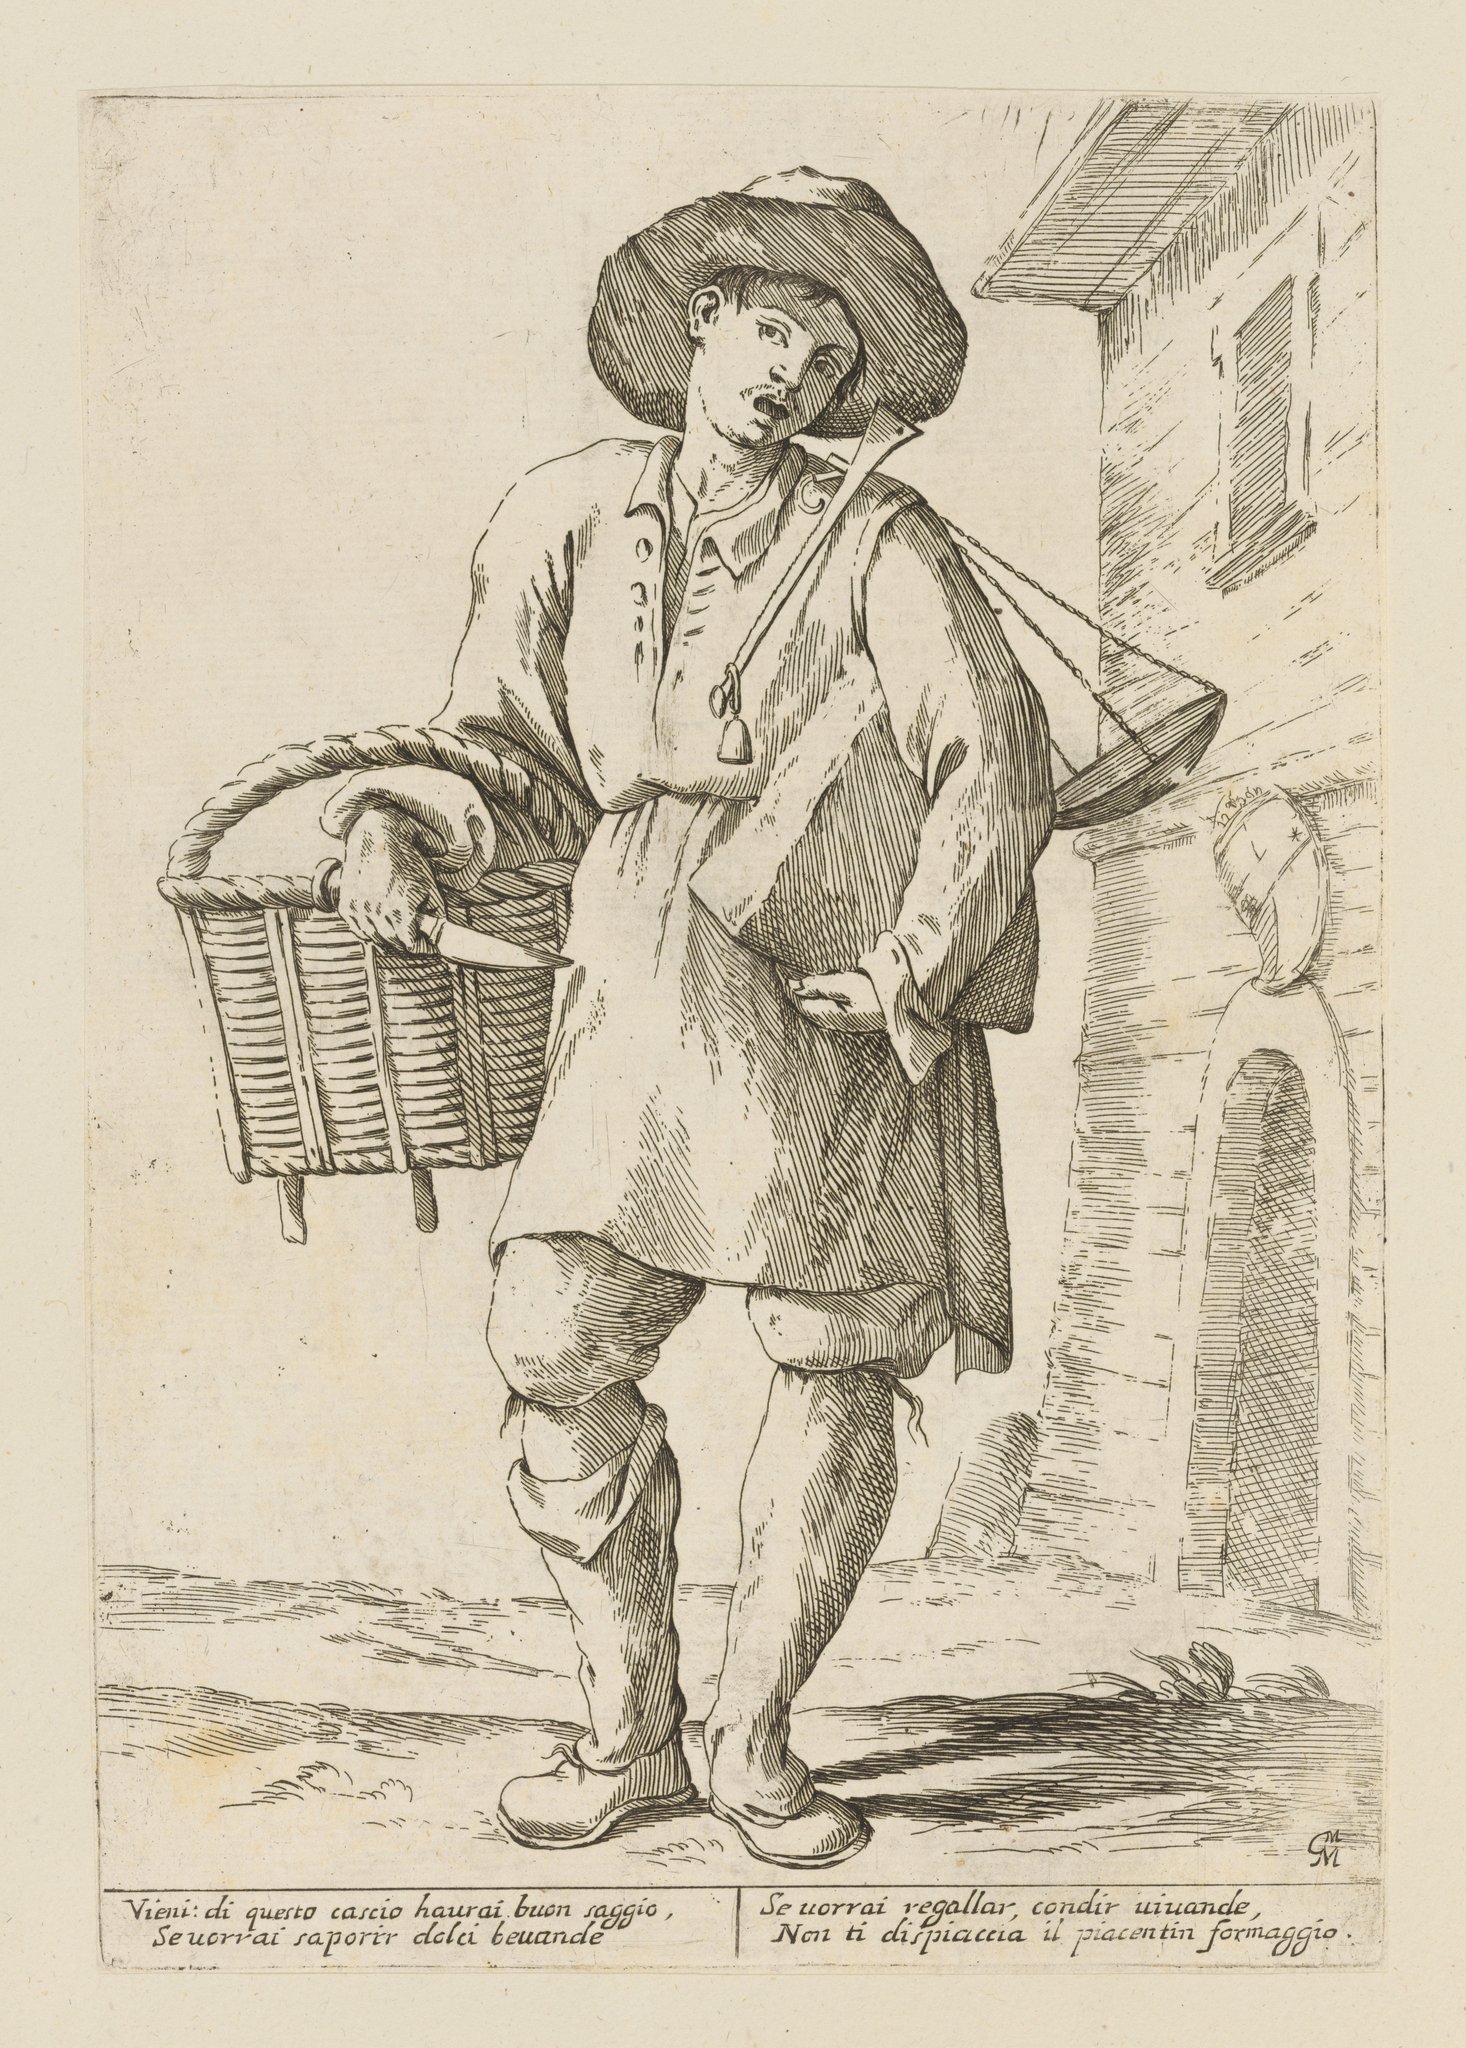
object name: print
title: Cheese Vendor, from Di Bologna l'Arti per via D'An.ibal' Ca.rac, plate 3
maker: giuseppe maria mitelli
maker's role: artist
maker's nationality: italian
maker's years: 1634-1718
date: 1660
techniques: etching